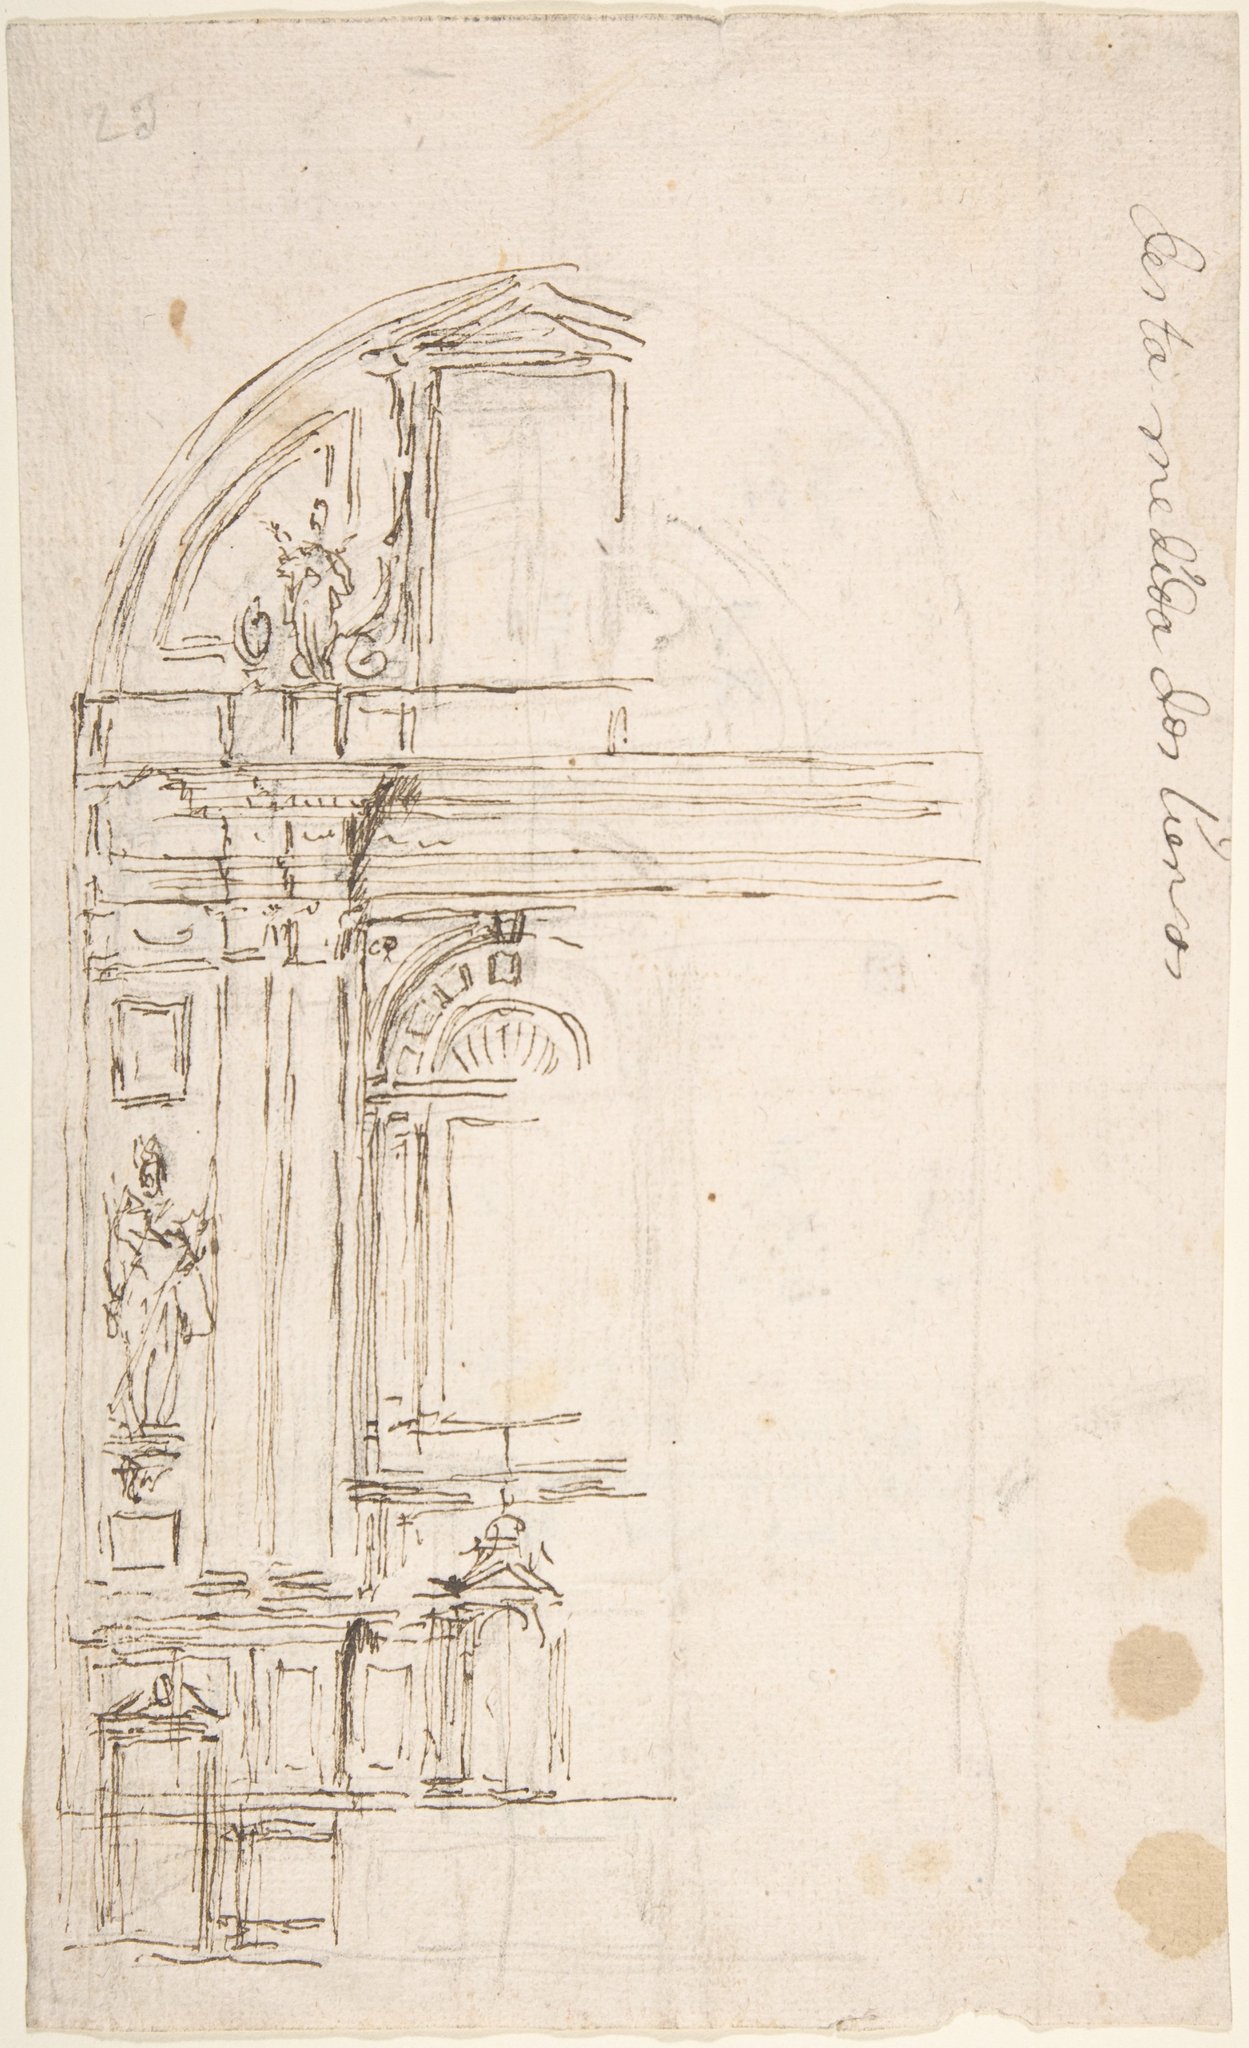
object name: drawing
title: Retablo Design with Figures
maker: anonymous, spanish, 18th century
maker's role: artist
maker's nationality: spanish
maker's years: 1700-1800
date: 1701-1800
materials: chalk, ink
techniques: pen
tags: altars